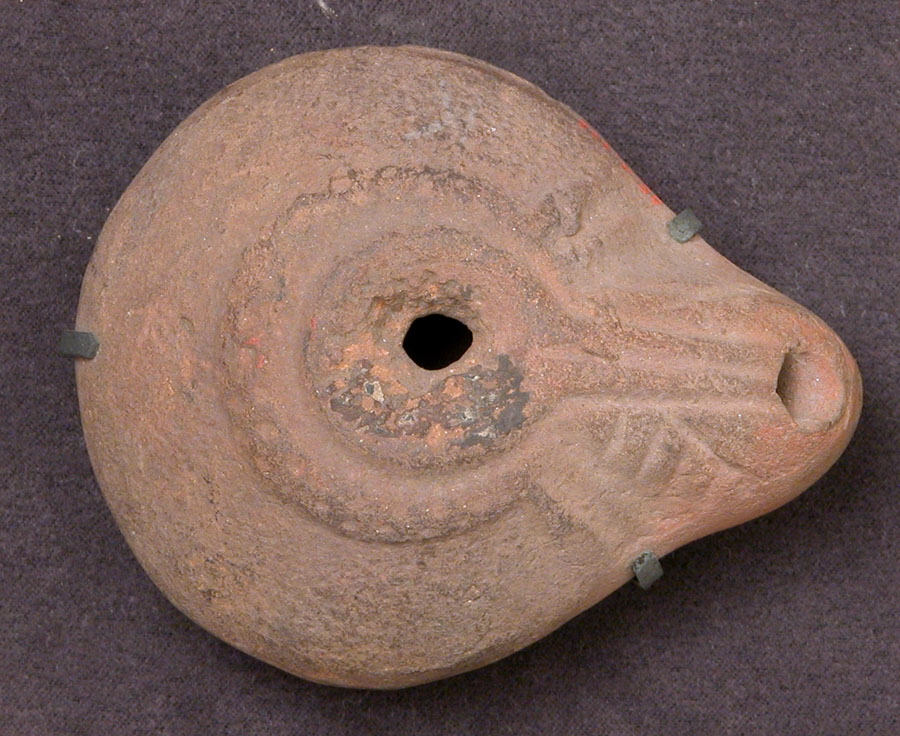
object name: lamp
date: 201-300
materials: earthenware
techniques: molding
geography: egypt